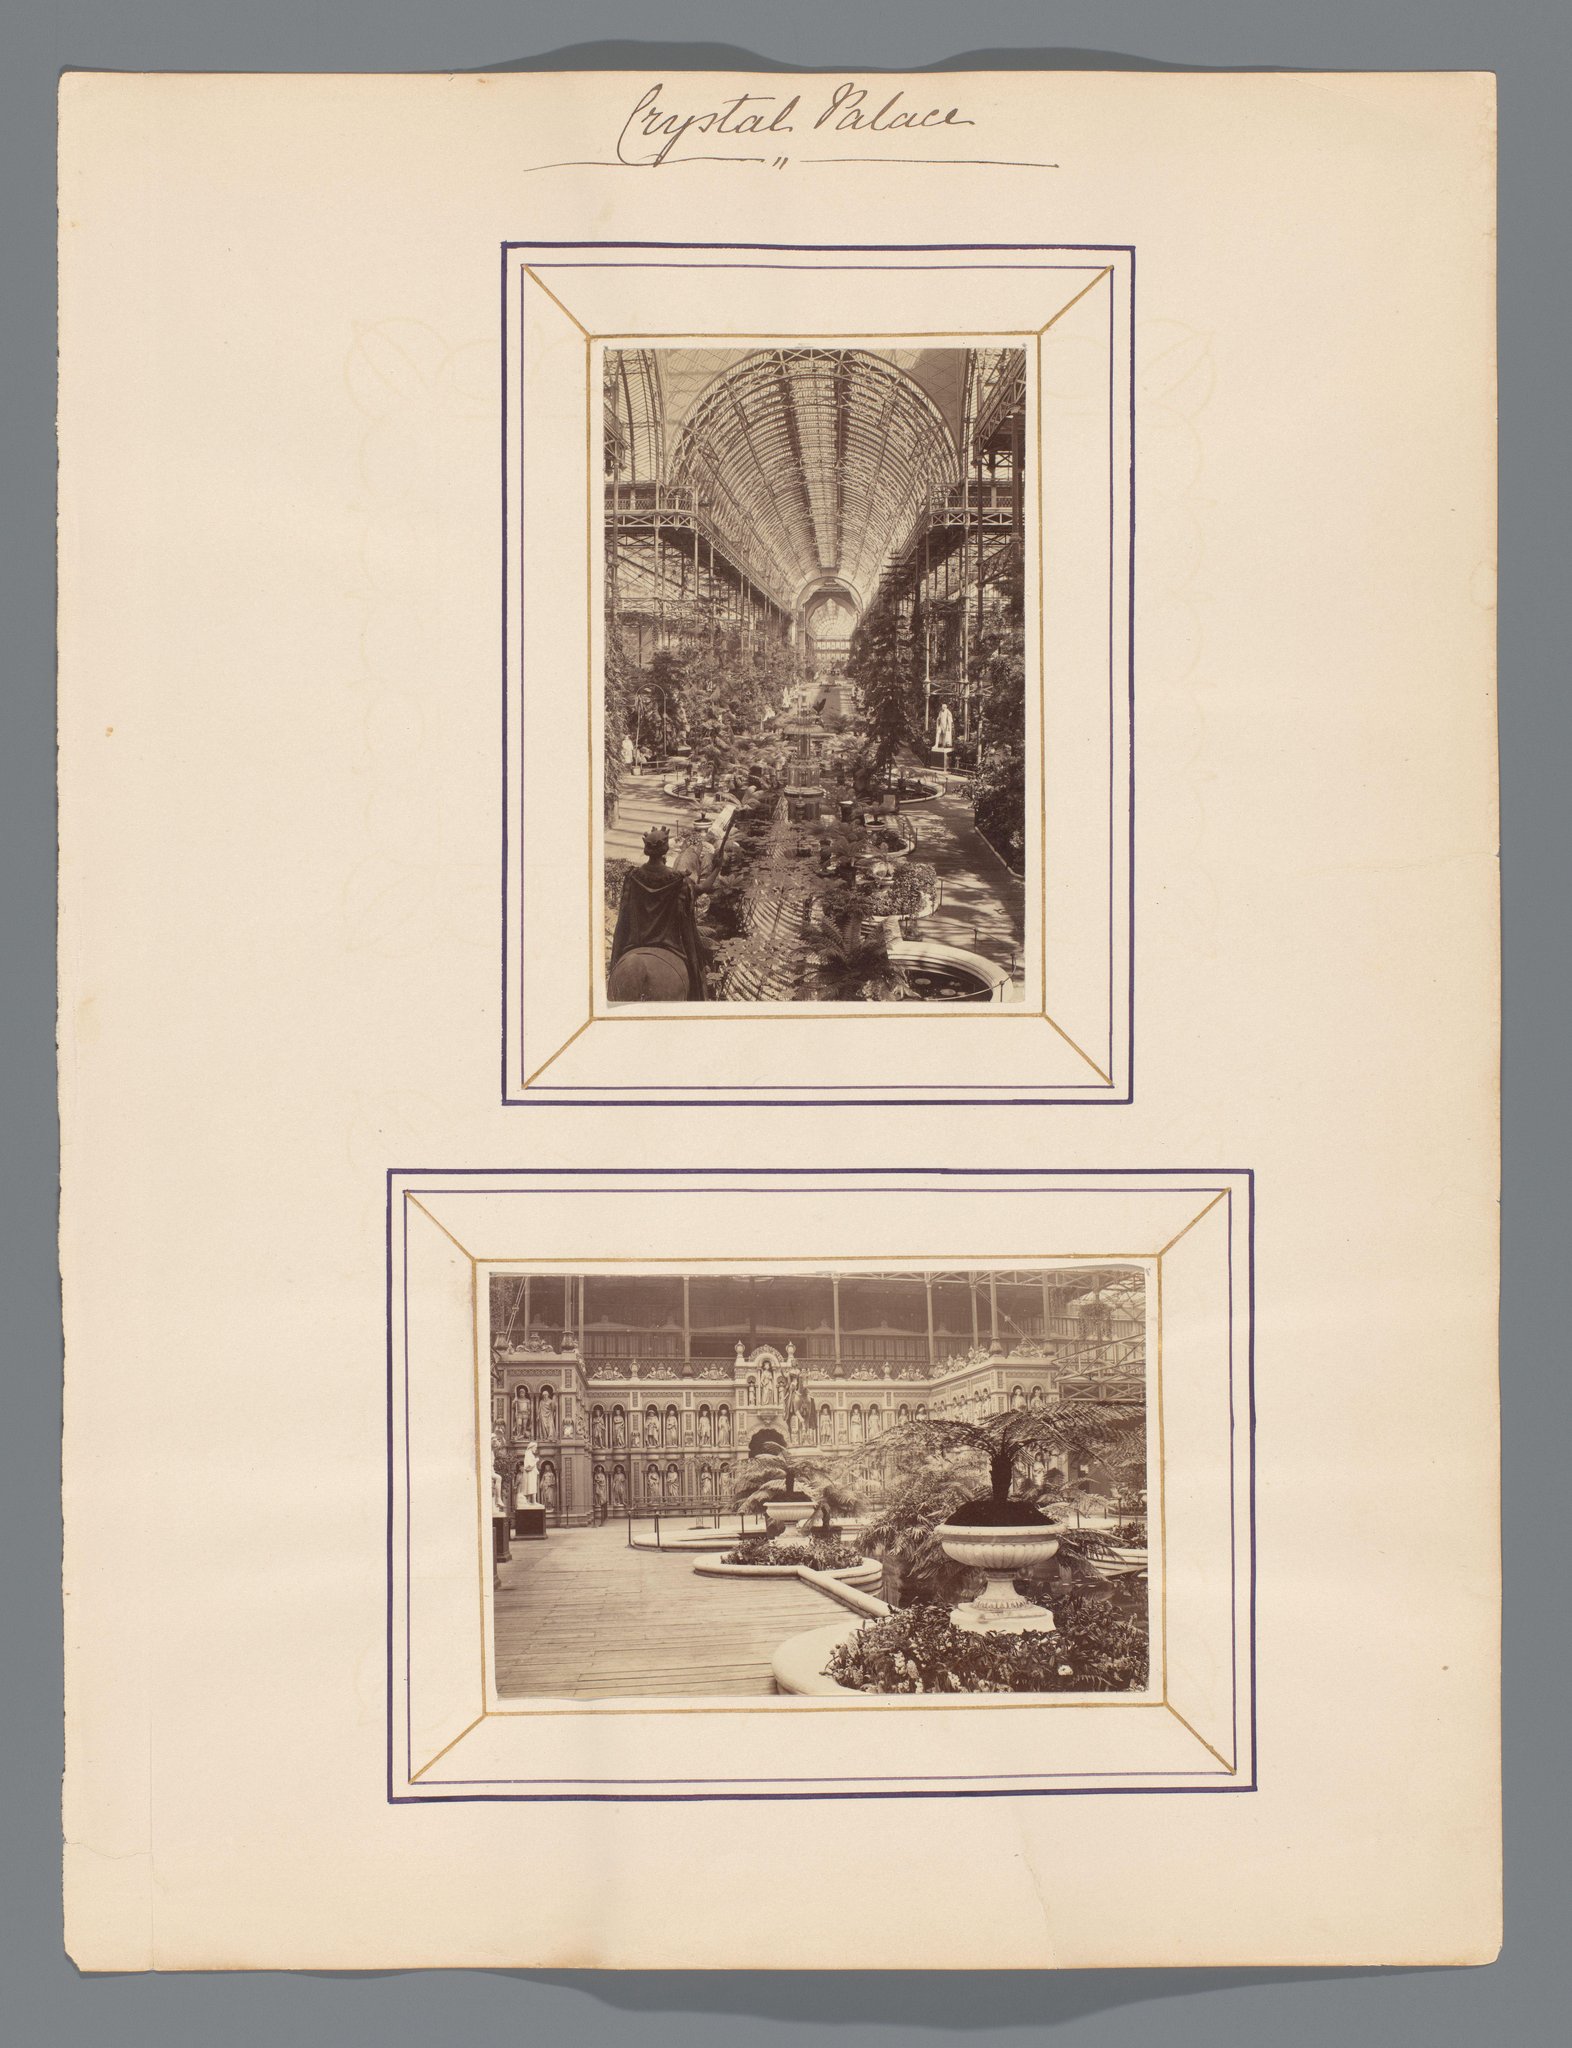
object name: photograph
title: Blad met twee foto's van Crystal Palace en randversiering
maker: Anonymous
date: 1860-1880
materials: ink, paper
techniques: albumen print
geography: london